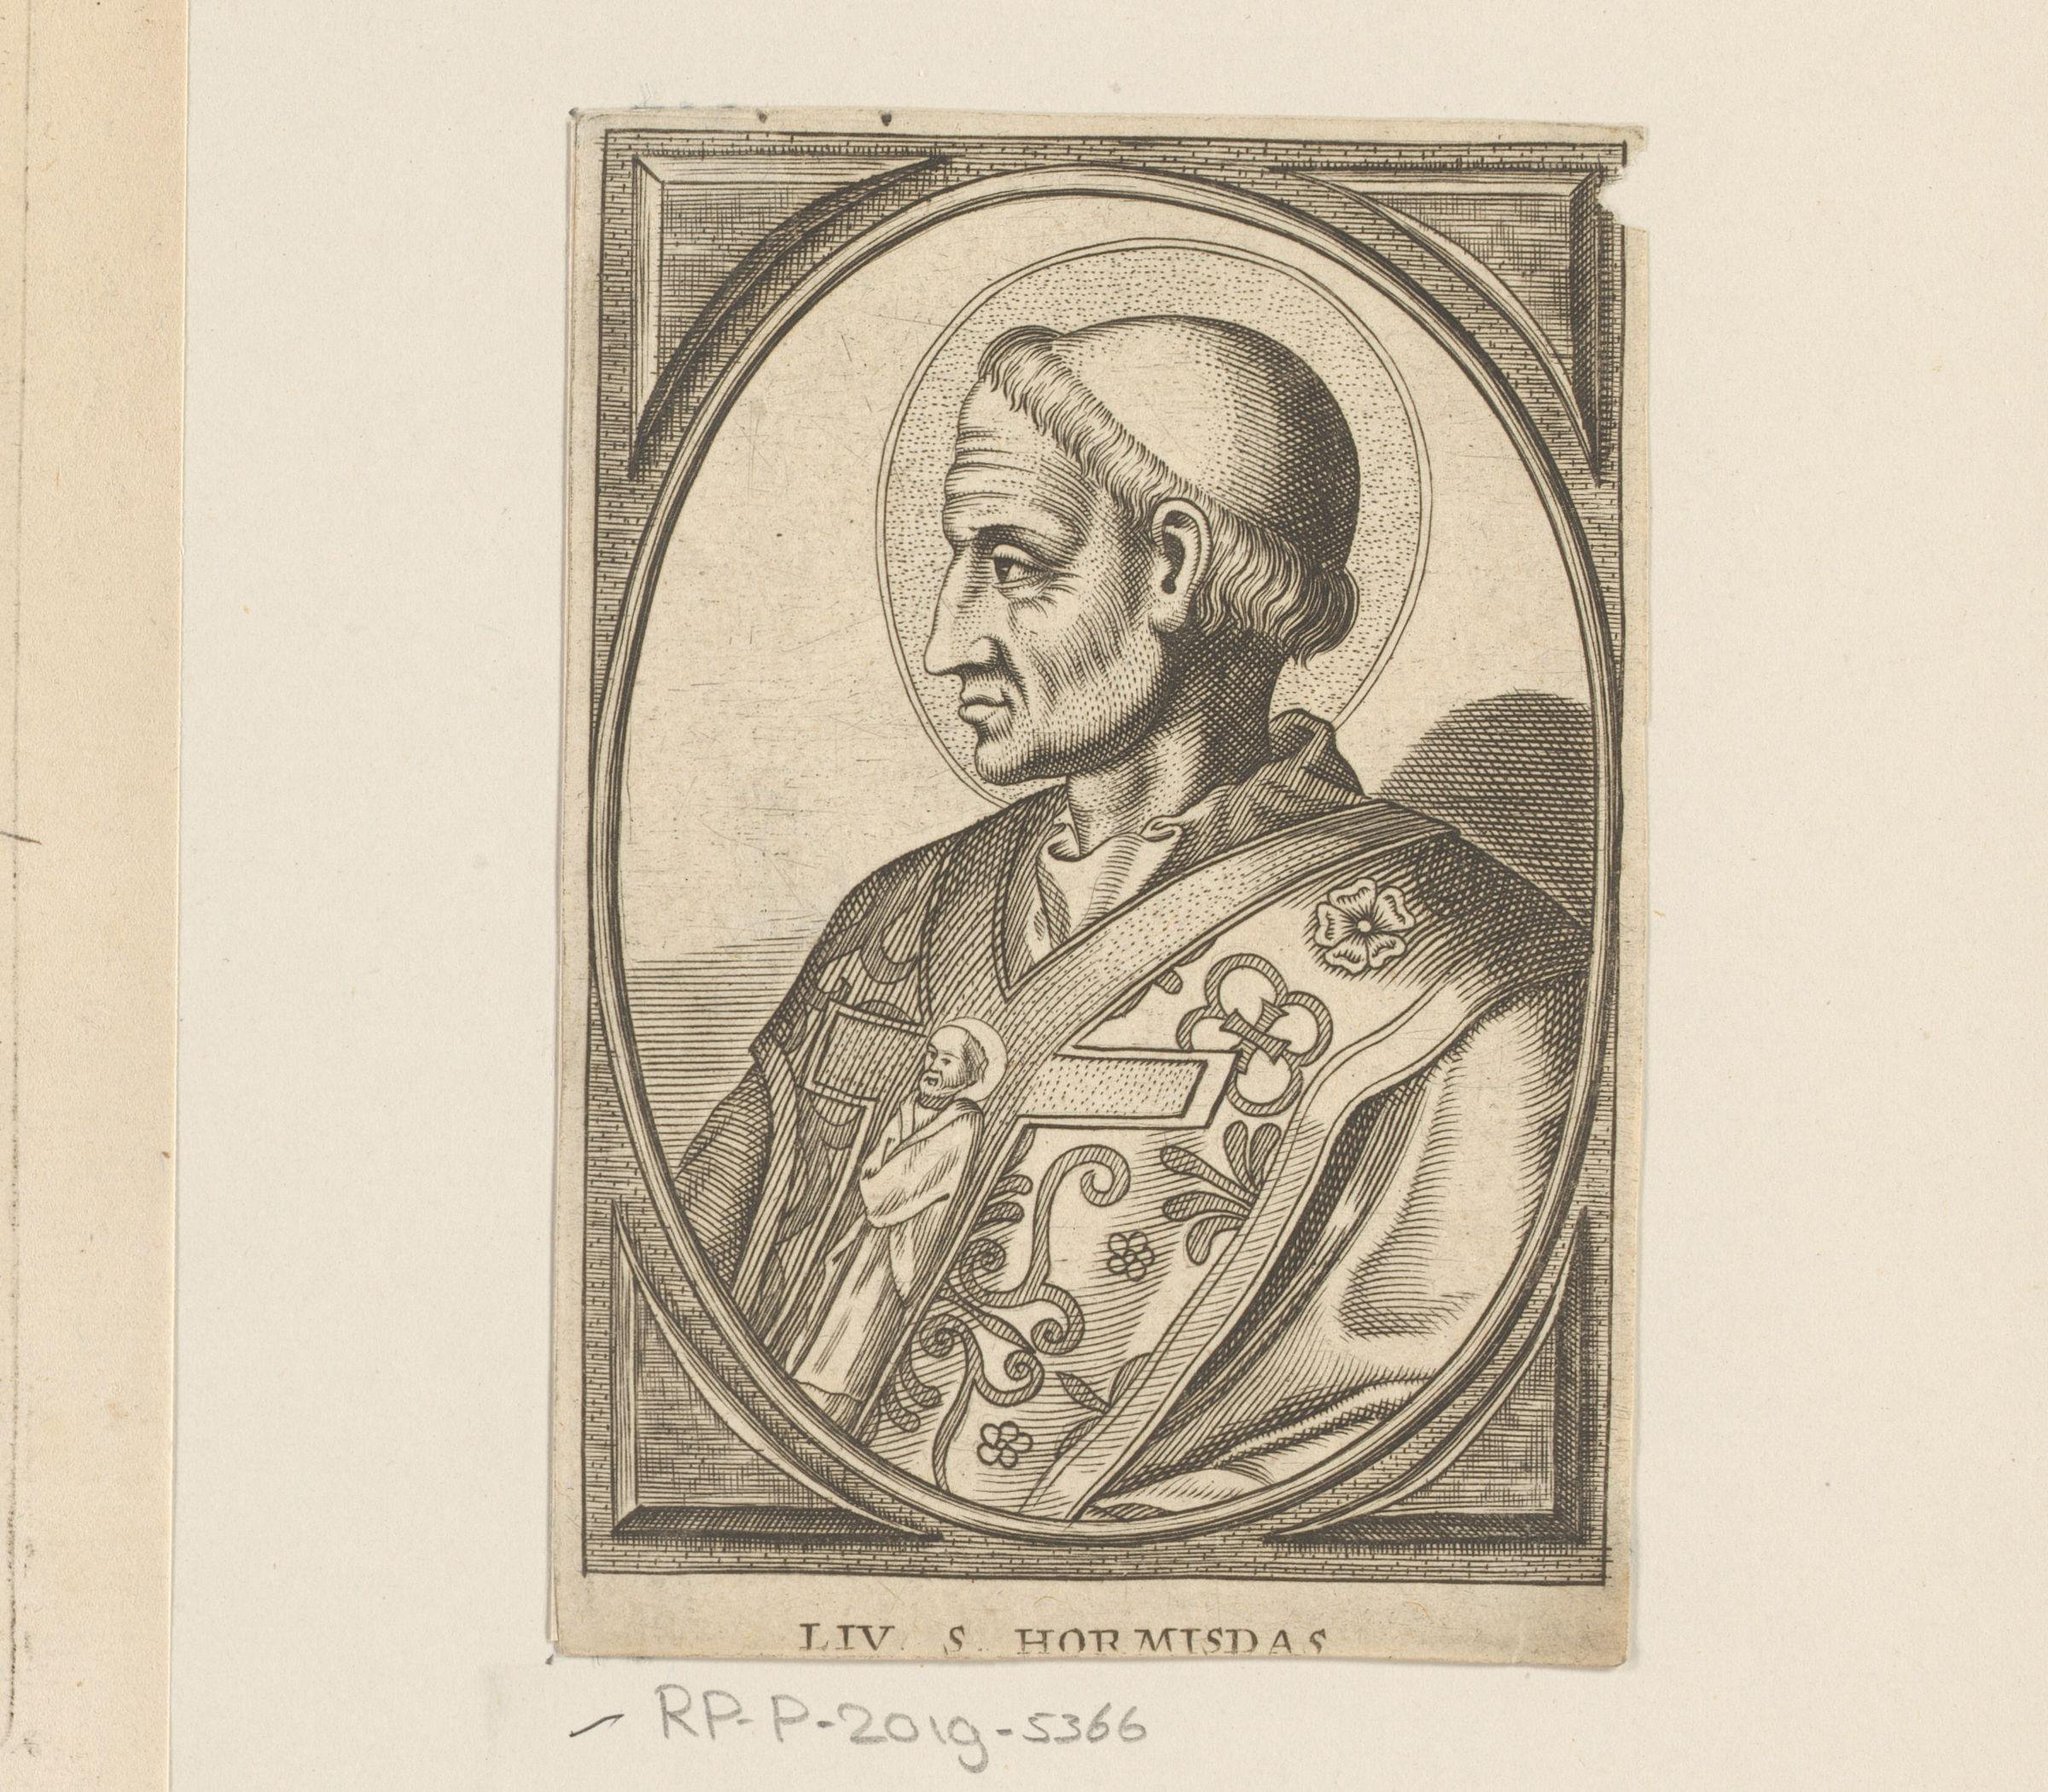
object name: print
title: Portret van paus Hormisdas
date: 1679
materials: paper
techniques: engraving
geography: antwerp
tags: rome, historical persons, pope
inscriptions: inscription: ‘4’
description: Prent uit: Hazart, Cornelius. Triomph der pausen van Roomen over alle hare benyders ende bestryders (...). Antwerpen: Michiel Cnobbaert, 1679, dl. 1. Prent ook gebruikt in andere publicaties van deze uitgever. Zie bijvoorbeeld: Propylaeum ad acta sanctorum maii sub felicissimus auspiciis Innocentii XI (...). Antwerpen: Michiel Cnobbaert, s.a.